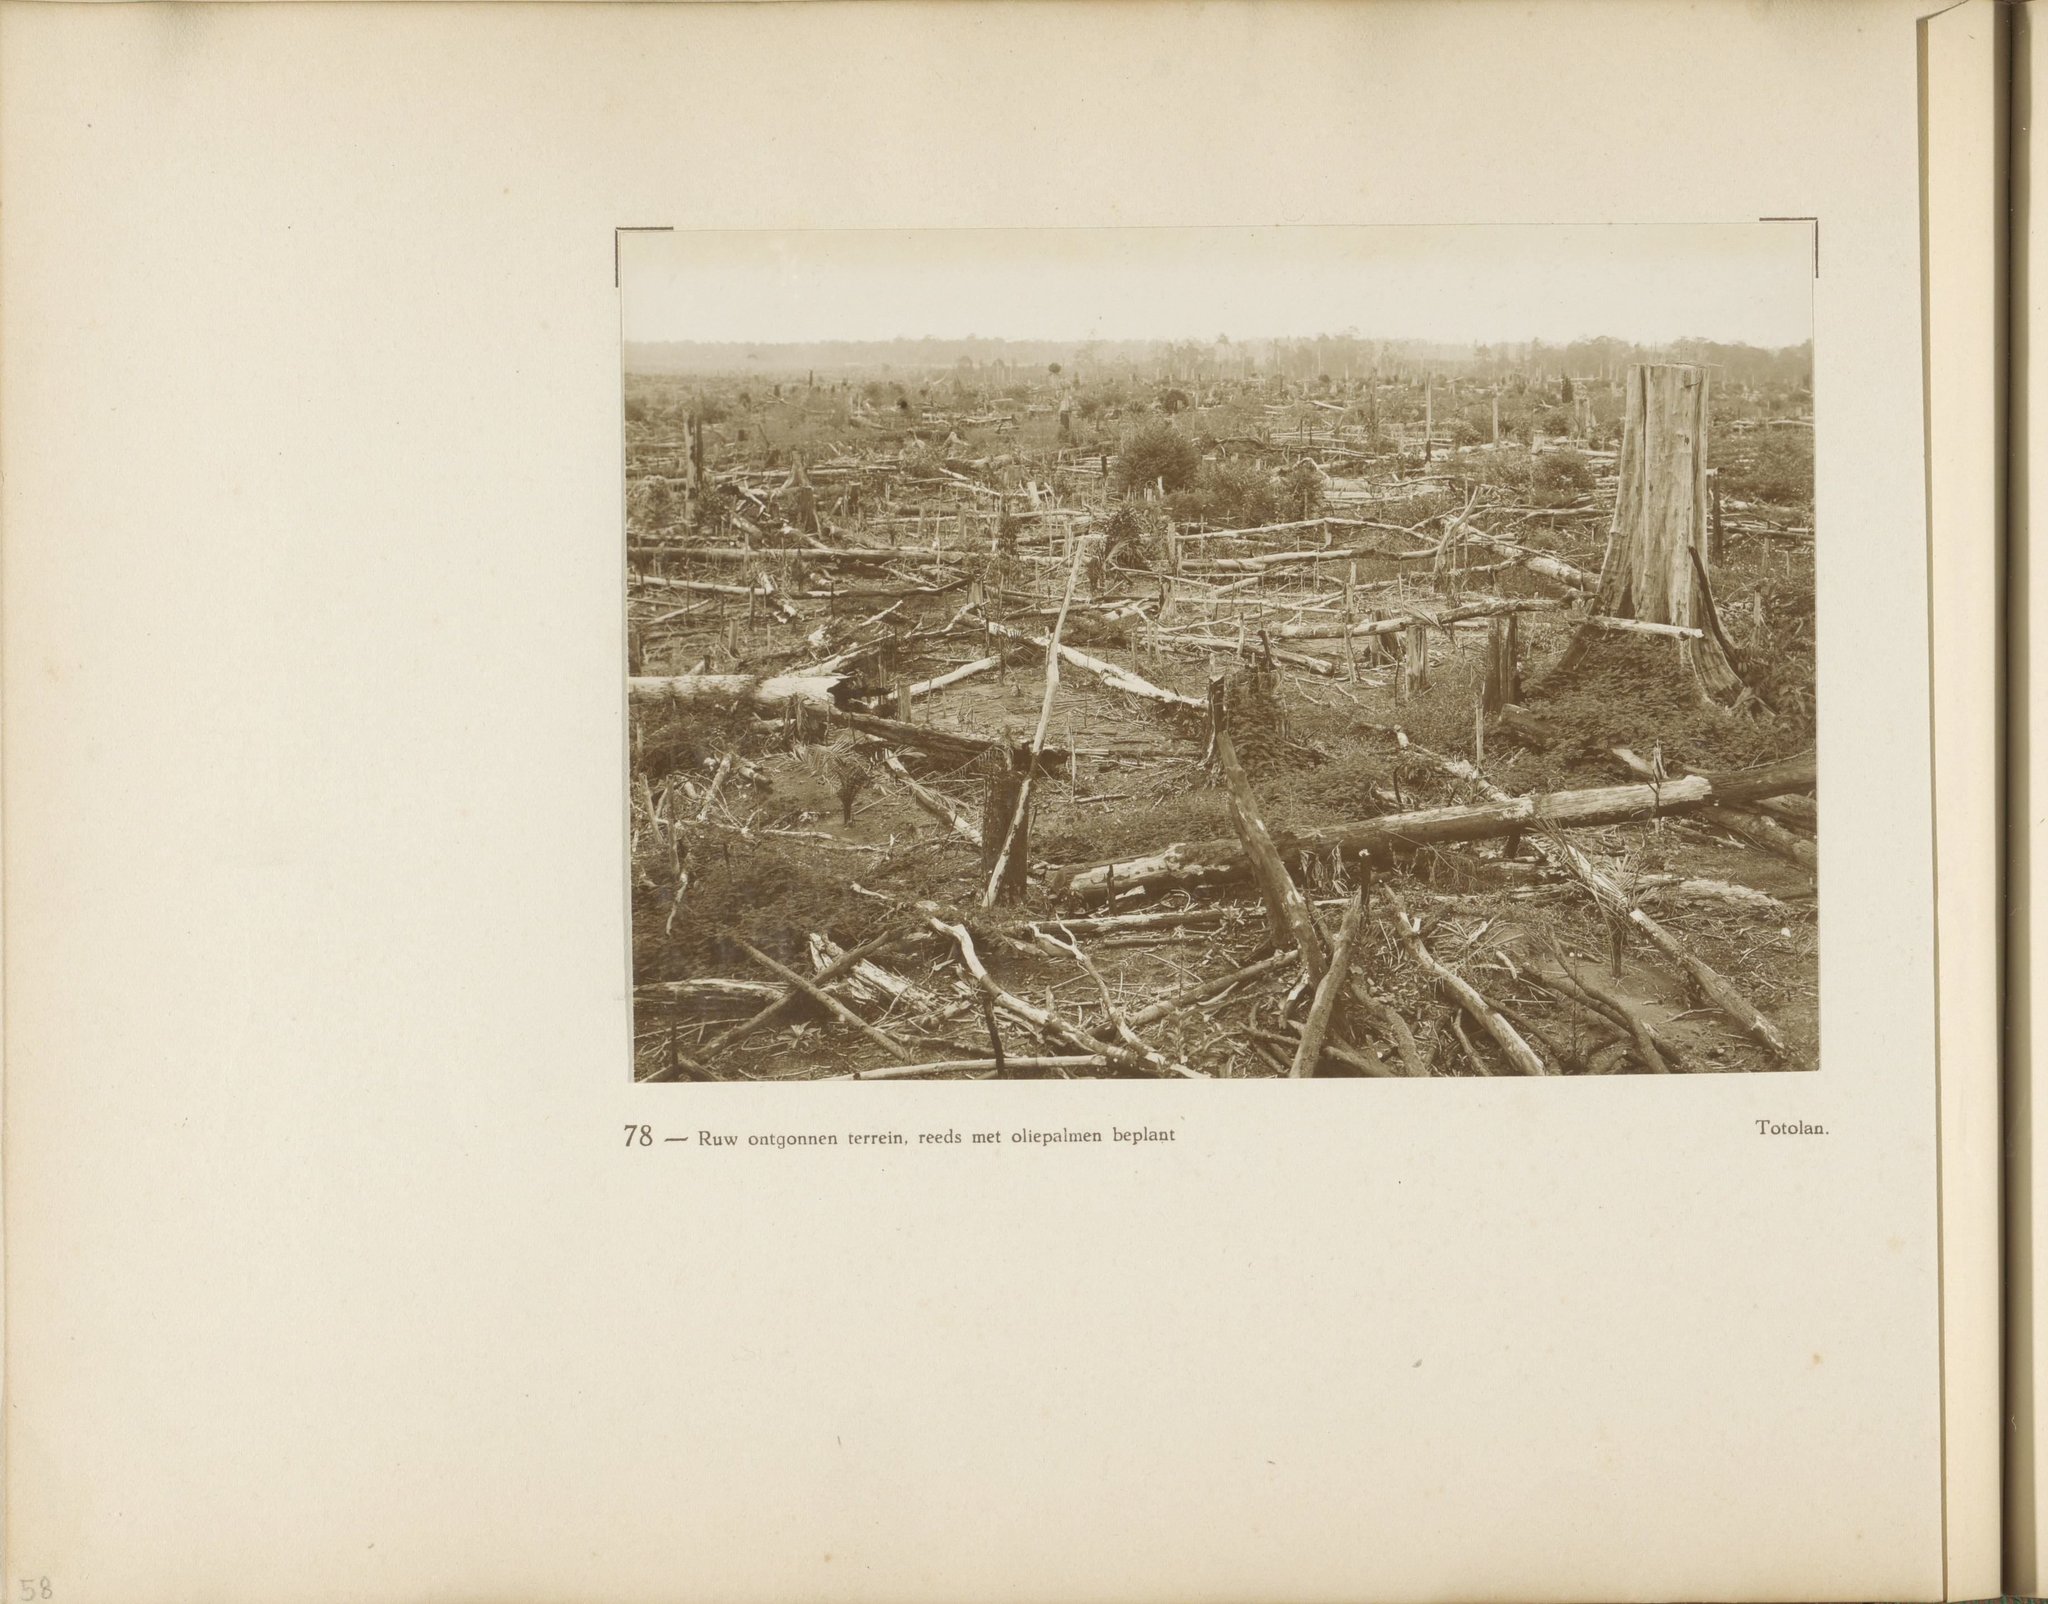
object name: photograph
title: Pagina 78 van fotoboek van de Algemeene Vereeniging van Rubberplanters ter Oostkust van Sumatra (A.V.R.O.S.)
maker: j.w. meyster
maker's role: fotograaf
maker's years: 1887-1945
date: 1924-1925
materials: paper, photographic support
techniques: printing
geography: sumatra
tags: (non-fruit) products of plants or trees: rubber, land-clearing, reclamation, trees: palm-tree, sumatra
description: Boekpagina met een foto van ruw ontgonnen terrein dat reeds met oliepalmen beplant is. Het perceel behoort bij een plantage van de Algemeene Vereeniging van Rubberplanters ter Oostkust van Sumatra (A.V.R.O.S.) te Totolan. Onderdeel van een fotoboek van de Algemeene Vereeniging van Rubberplanters ter Oostkust van Sumatra (A.V.R.O.S.).